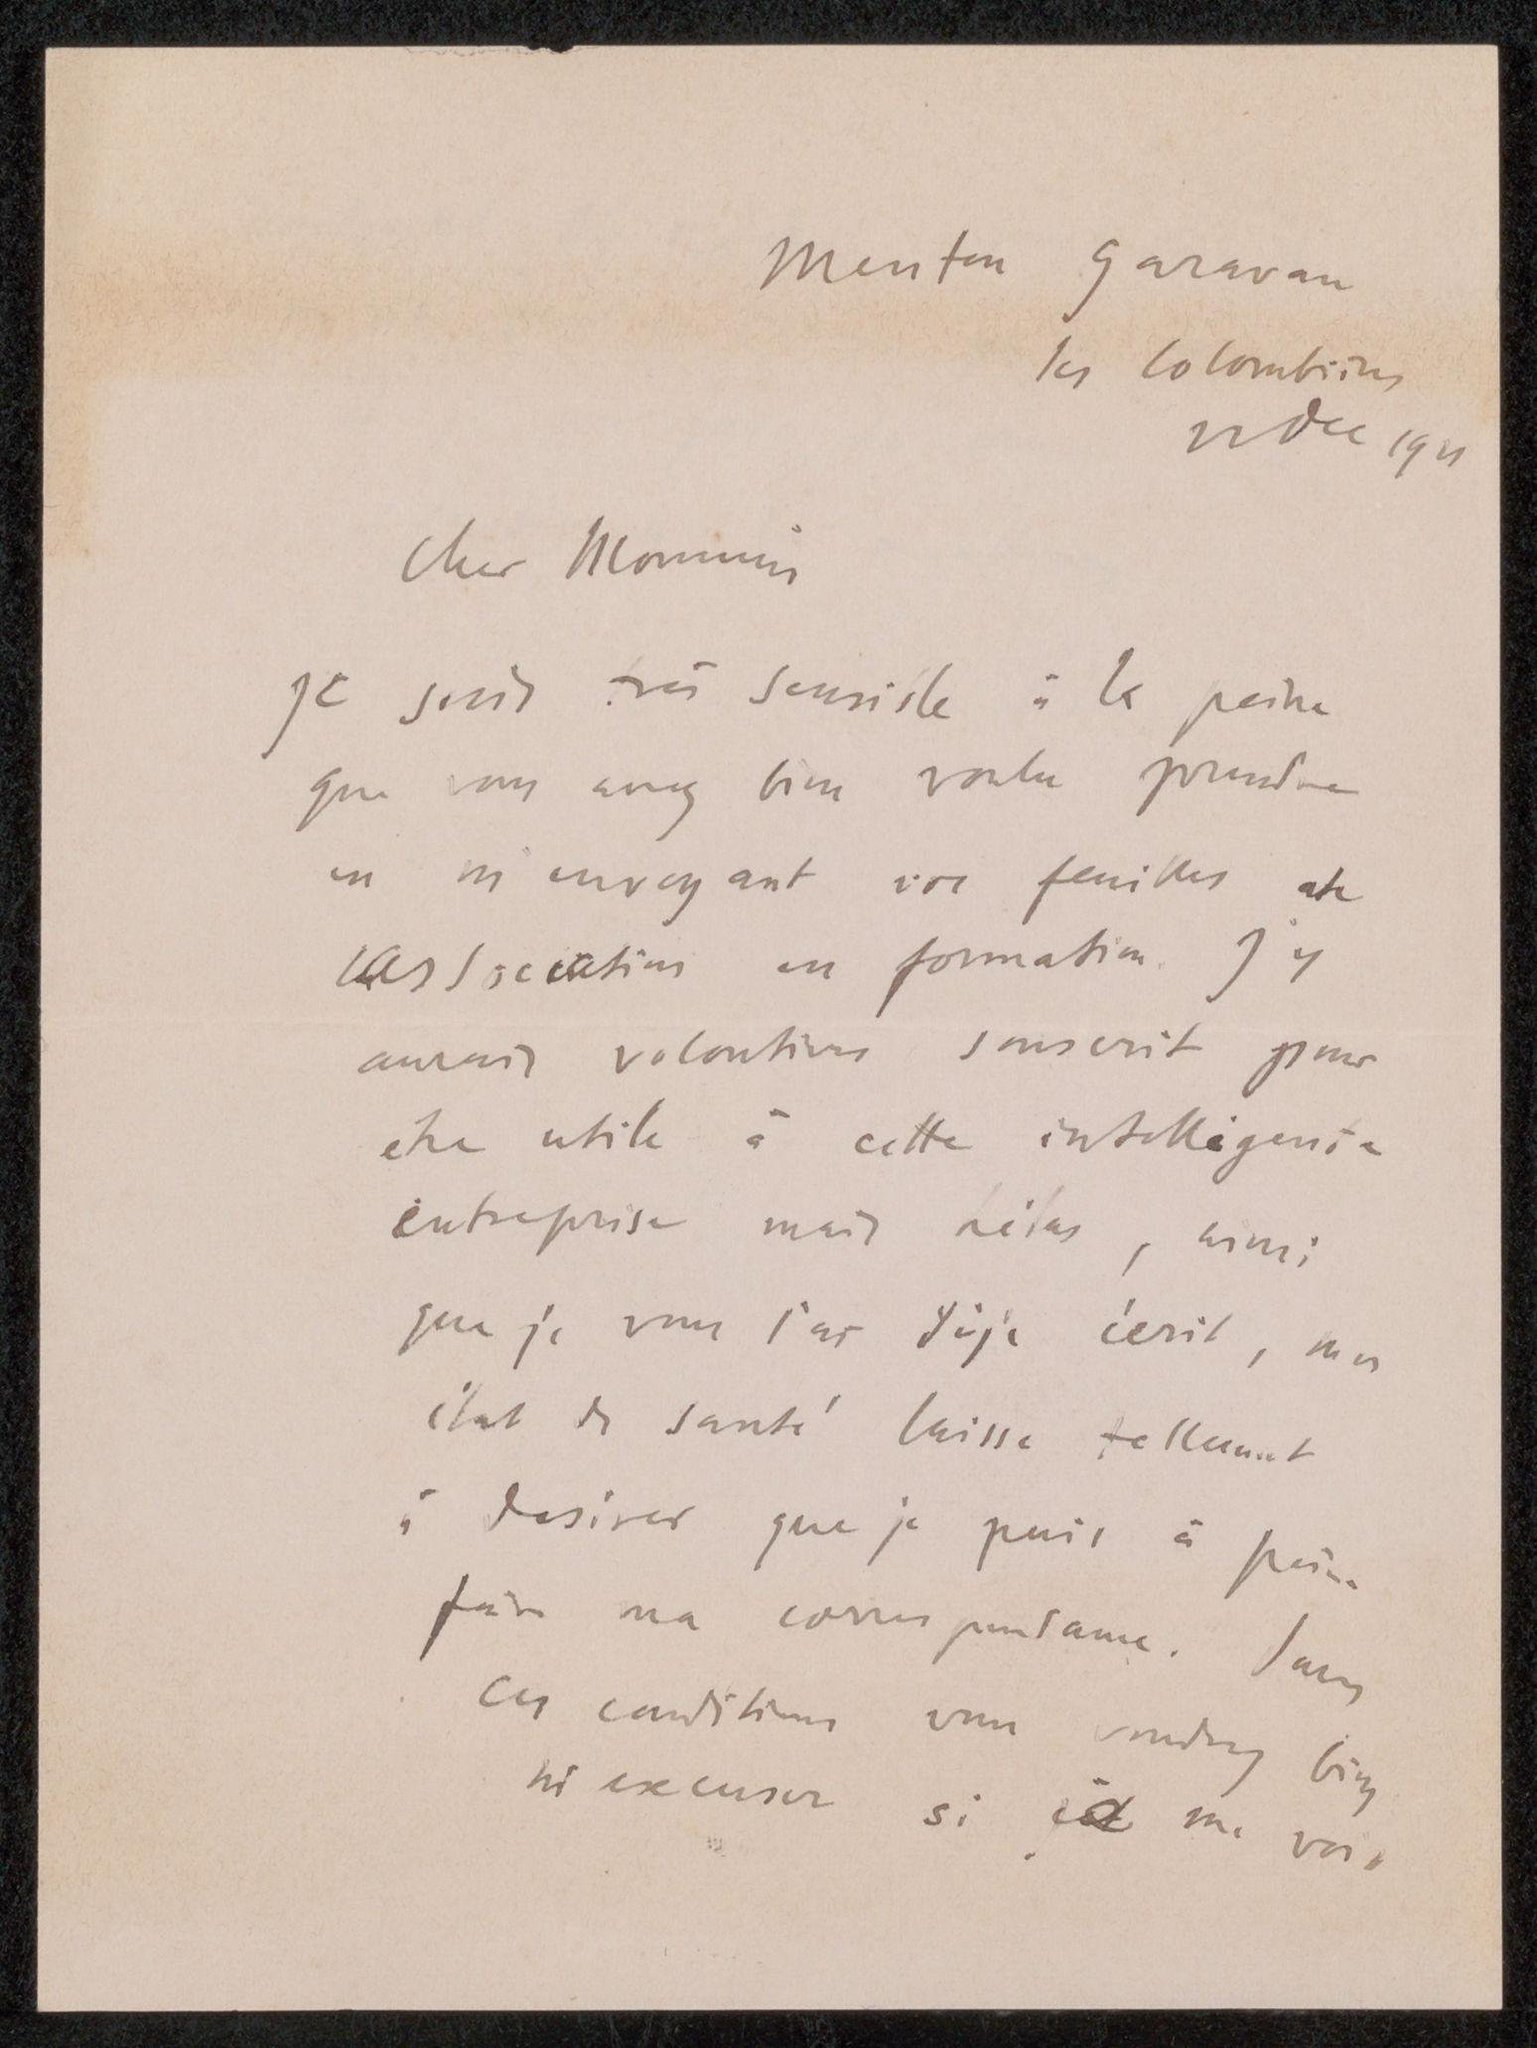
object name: letter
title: Brief aan Philip Zilcken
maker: ferdinand-sigismund bac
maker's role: draughtsman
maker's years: 1859-1952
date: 1921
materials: ink, paper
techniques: pen, writing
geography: menton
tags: the hague, draughtsman, philip zilcken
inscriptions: collector's mark: ‘RPK’